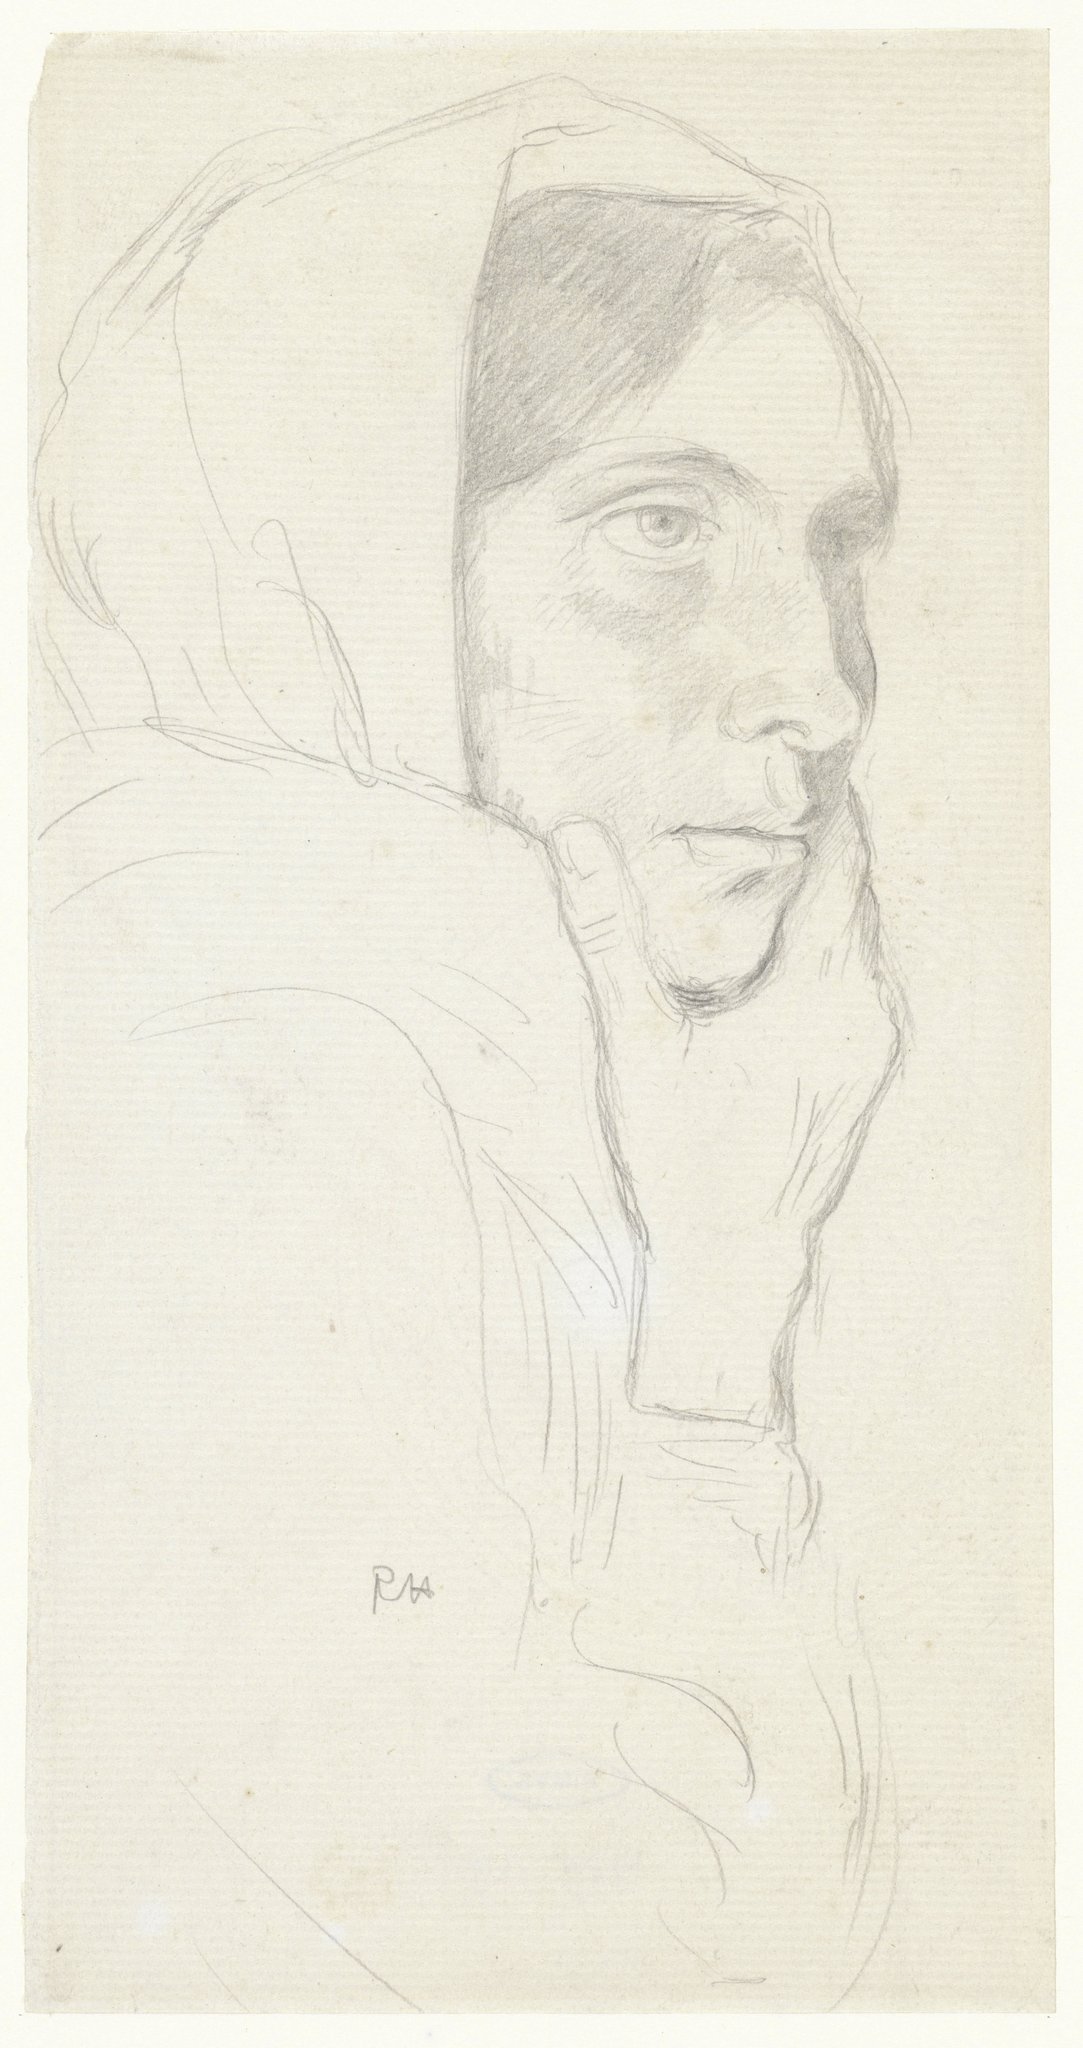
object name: drawing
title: Marie Hamel in De Opstandelingen van Henriëtte Roland Holst-van der Schalk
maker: richard nicolaüs roland holst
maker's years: 1868-1938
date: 1878-1938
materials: paper, pencil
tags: historical persons